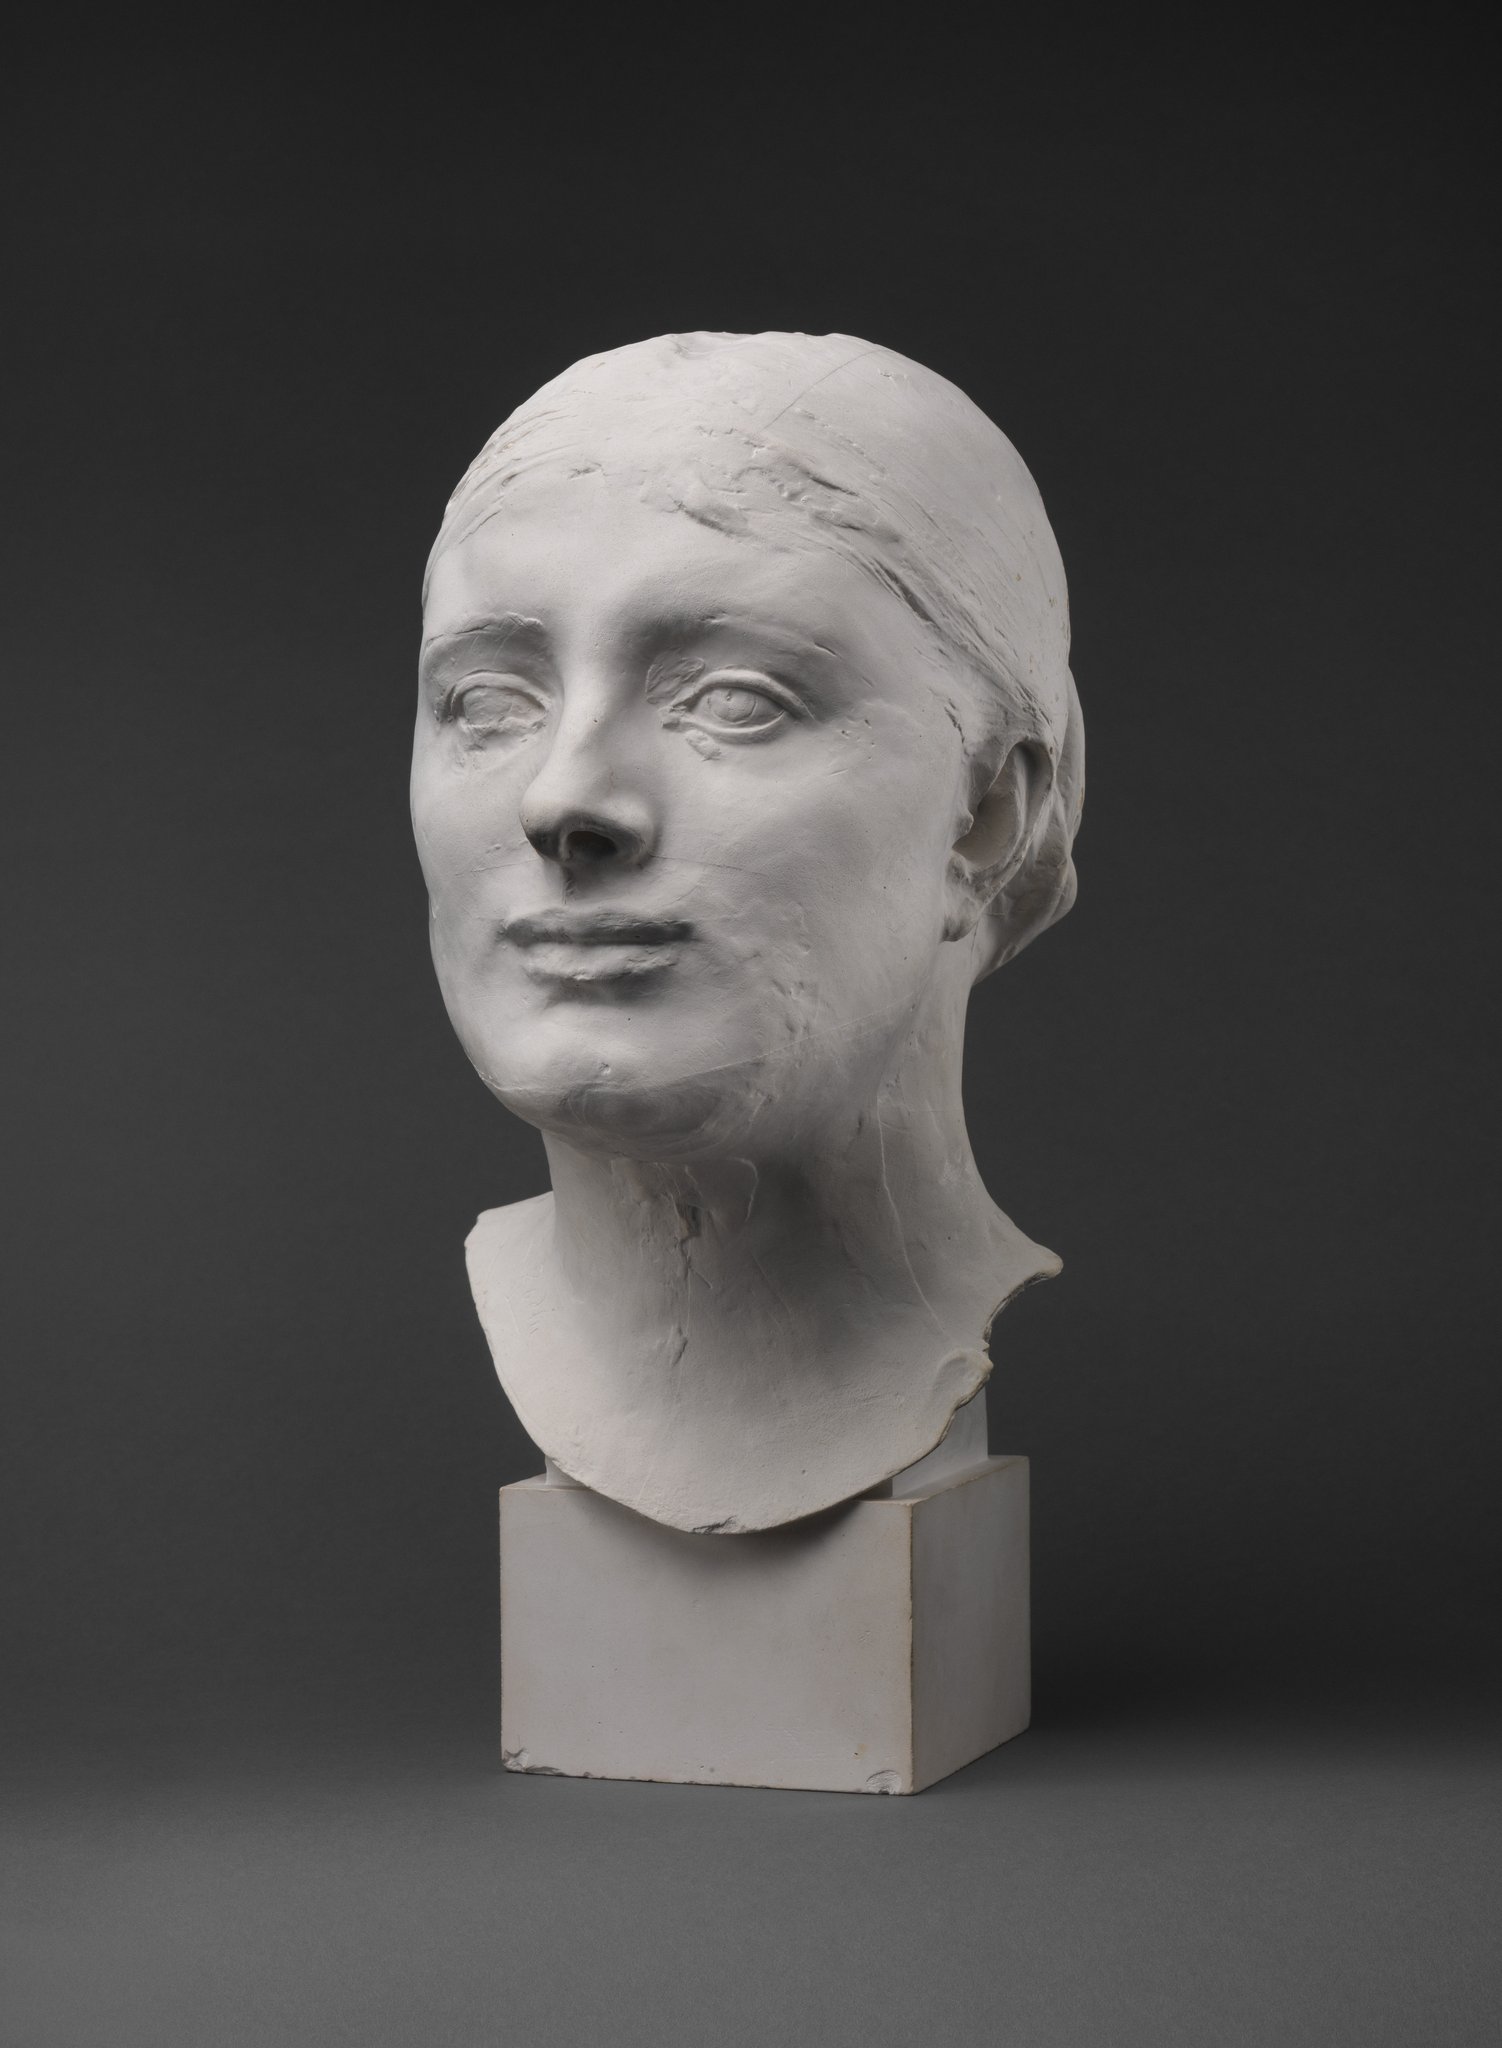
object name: bust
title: The Head of Mrs. Russell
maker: auguste rodin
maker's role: artist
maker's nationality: french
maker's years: 1840-1917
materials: plaster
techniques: casting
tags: heads,portraits,women